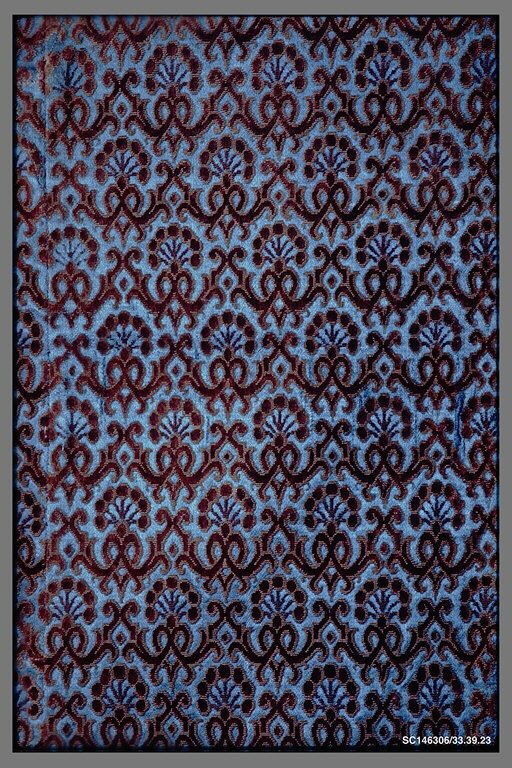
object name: fragment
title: Length of voided velvet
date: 1601-1700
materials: silk, velvet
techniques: cutting, voiding